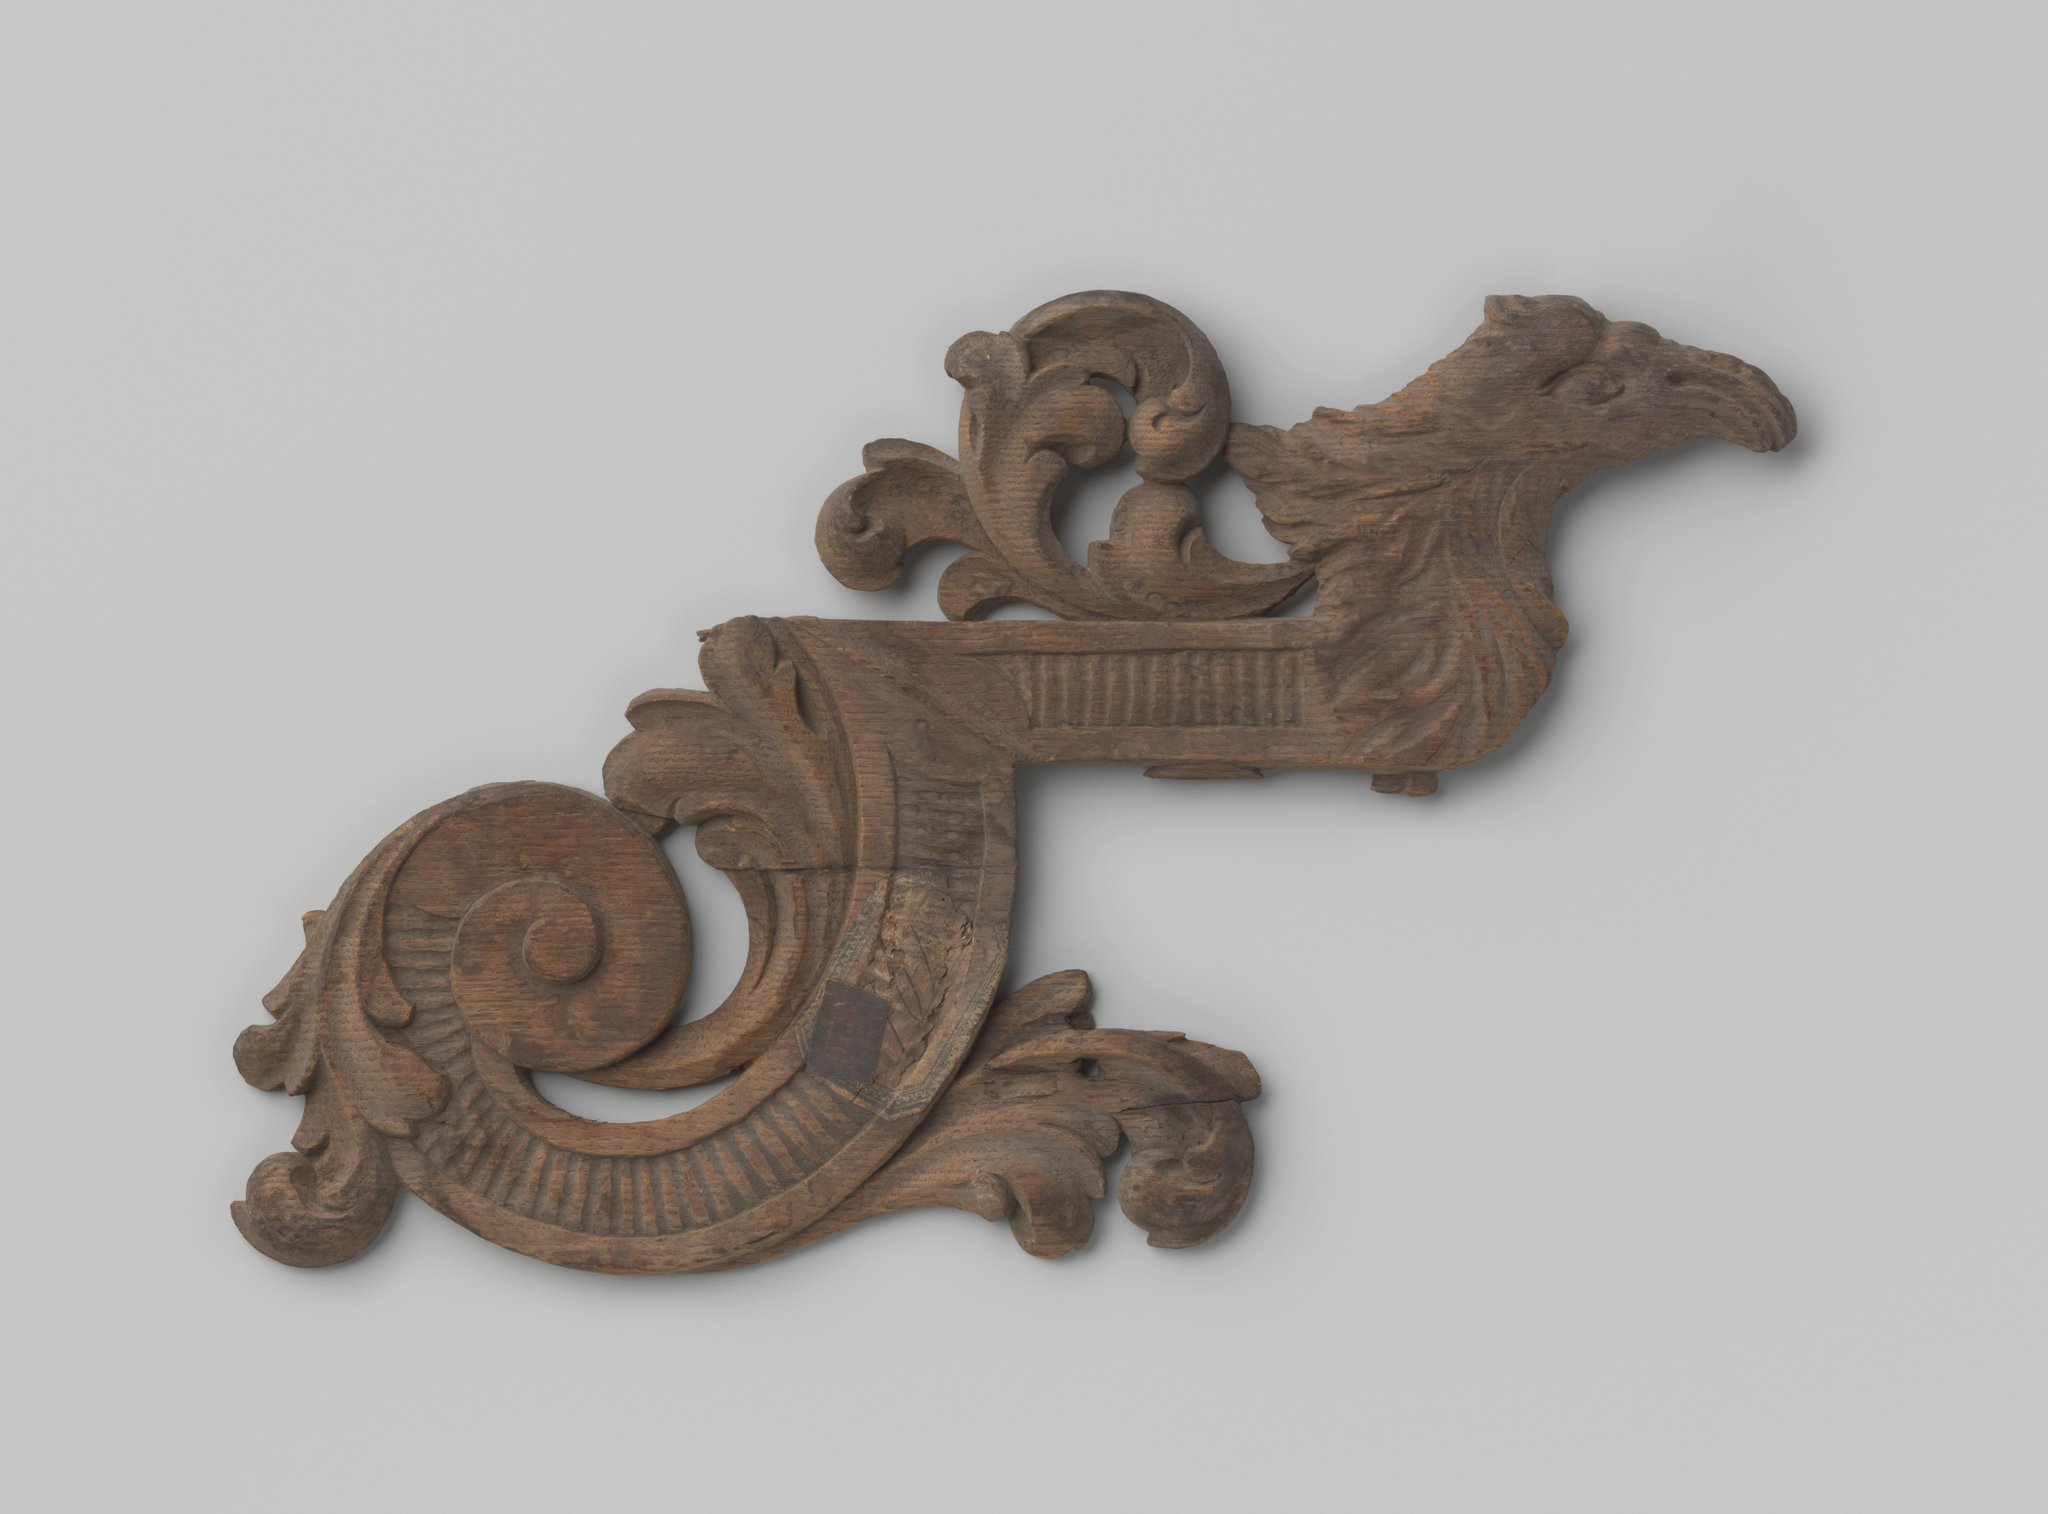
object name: woodcarving visual work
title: Snijwerk van eikenhout met ornamenten en vogelkop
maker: Anonymous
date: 1600-1800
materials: wood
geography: netherlands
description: Snijwerk van eikenhout met ornamenten en vogelkop.